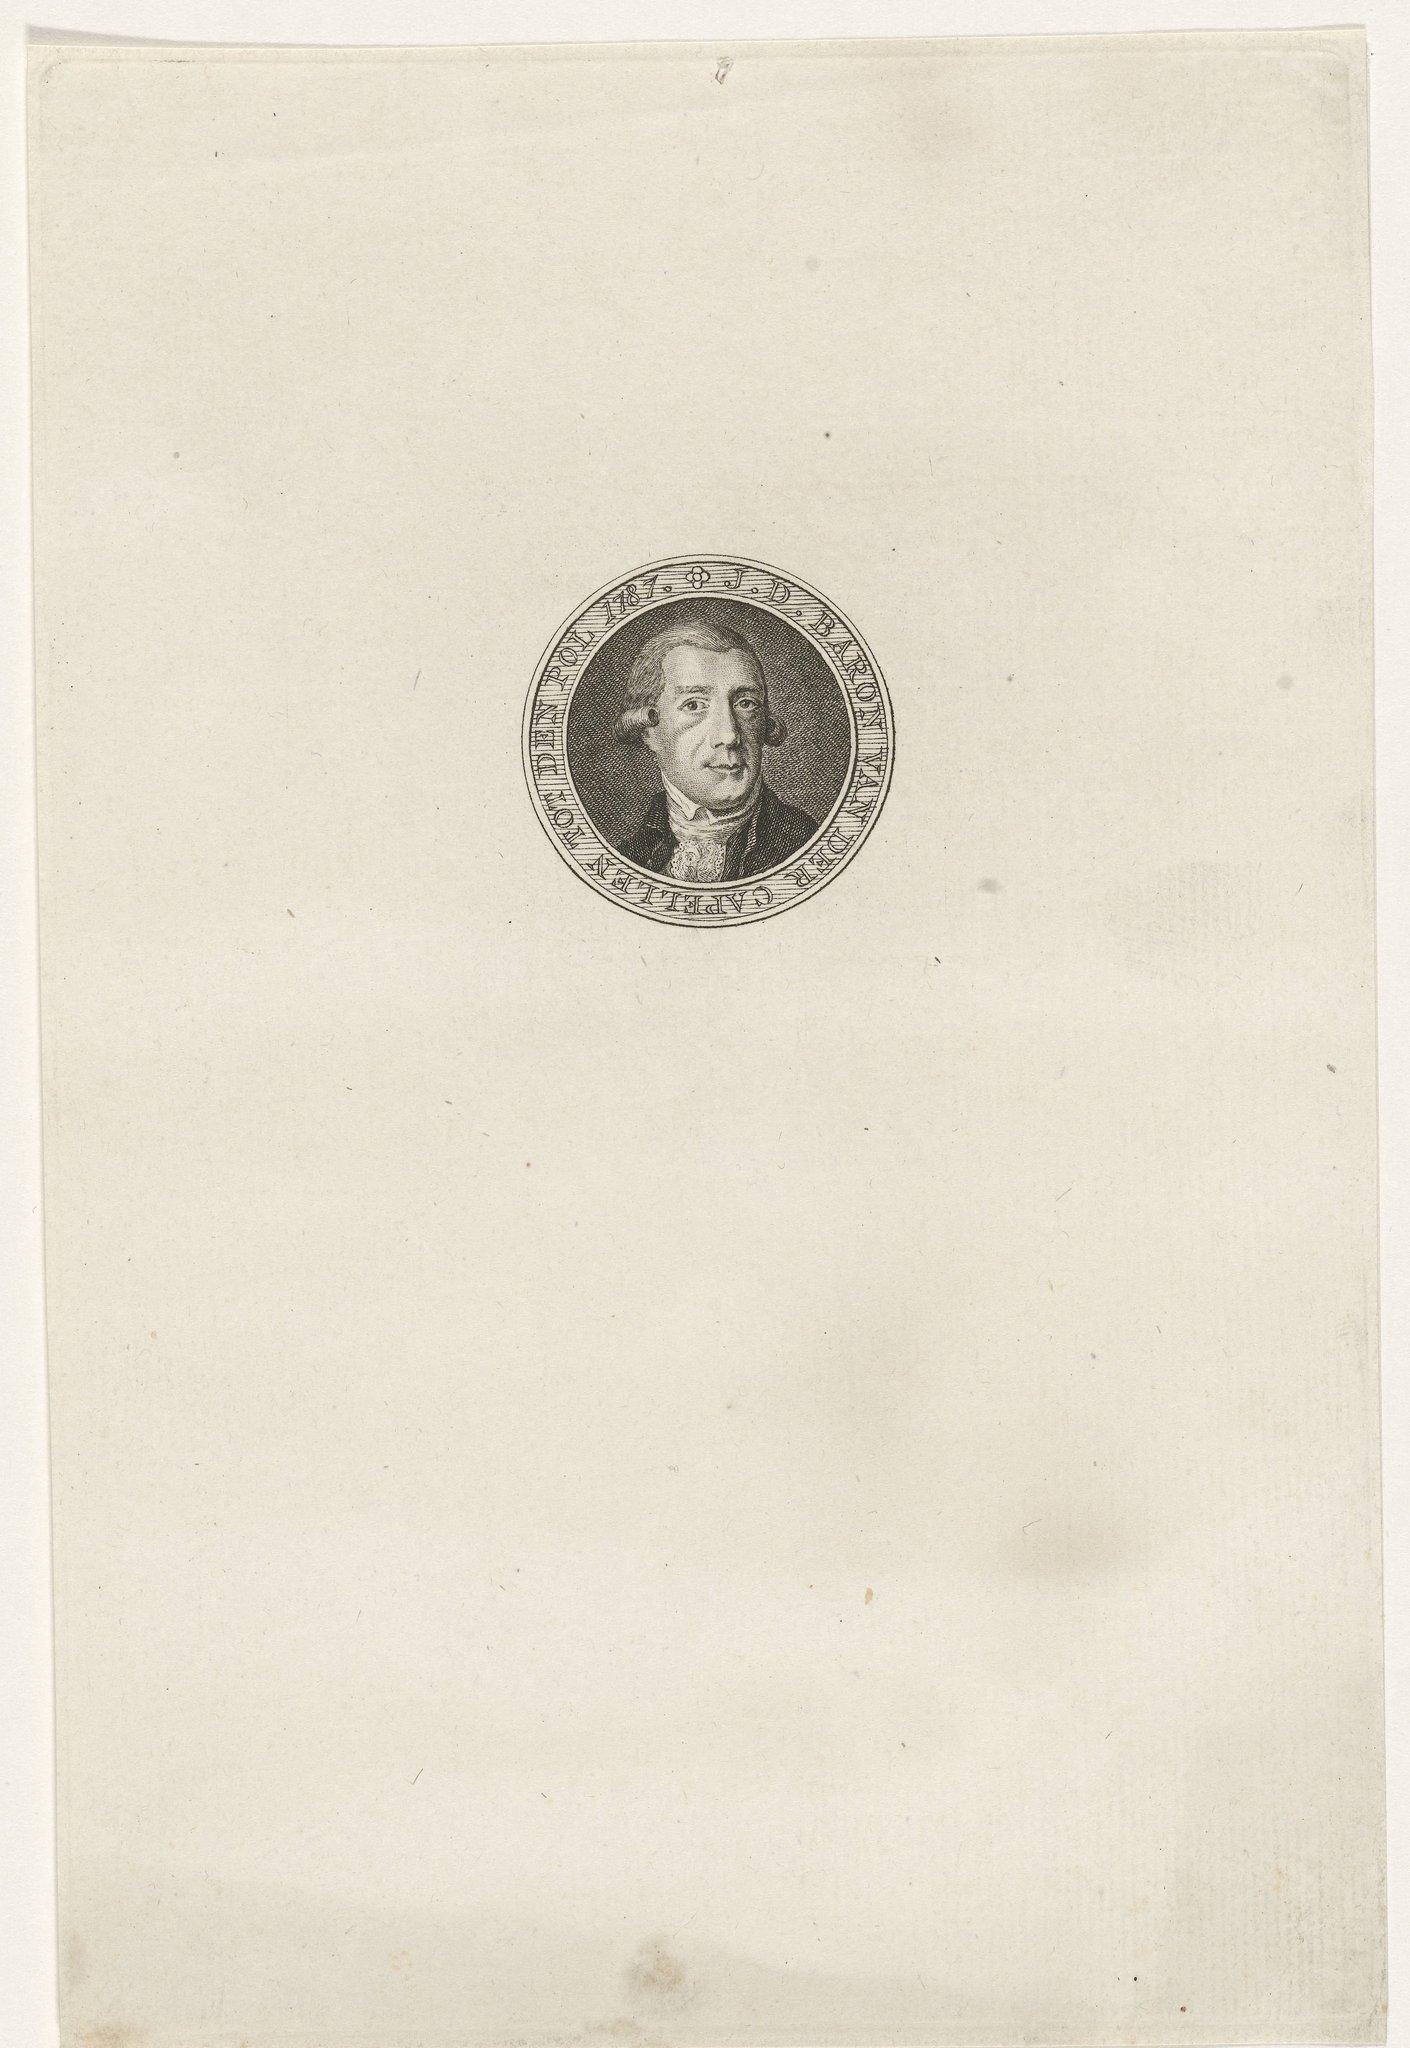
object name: print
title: Portret van Joan Derk van der Capellen tot den Pol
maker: abraham jacobsz. hulk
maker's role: print maker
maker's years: 1751-1817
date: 1787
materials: paper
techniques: engraving, etching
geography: paris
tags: politician, joan derk van der capellen tot den pol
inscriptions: date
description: De plaat van deze prent werd door Jacobus Wijsman aangepast en hergebruikt in zijn eigen serie patriottenportretten.